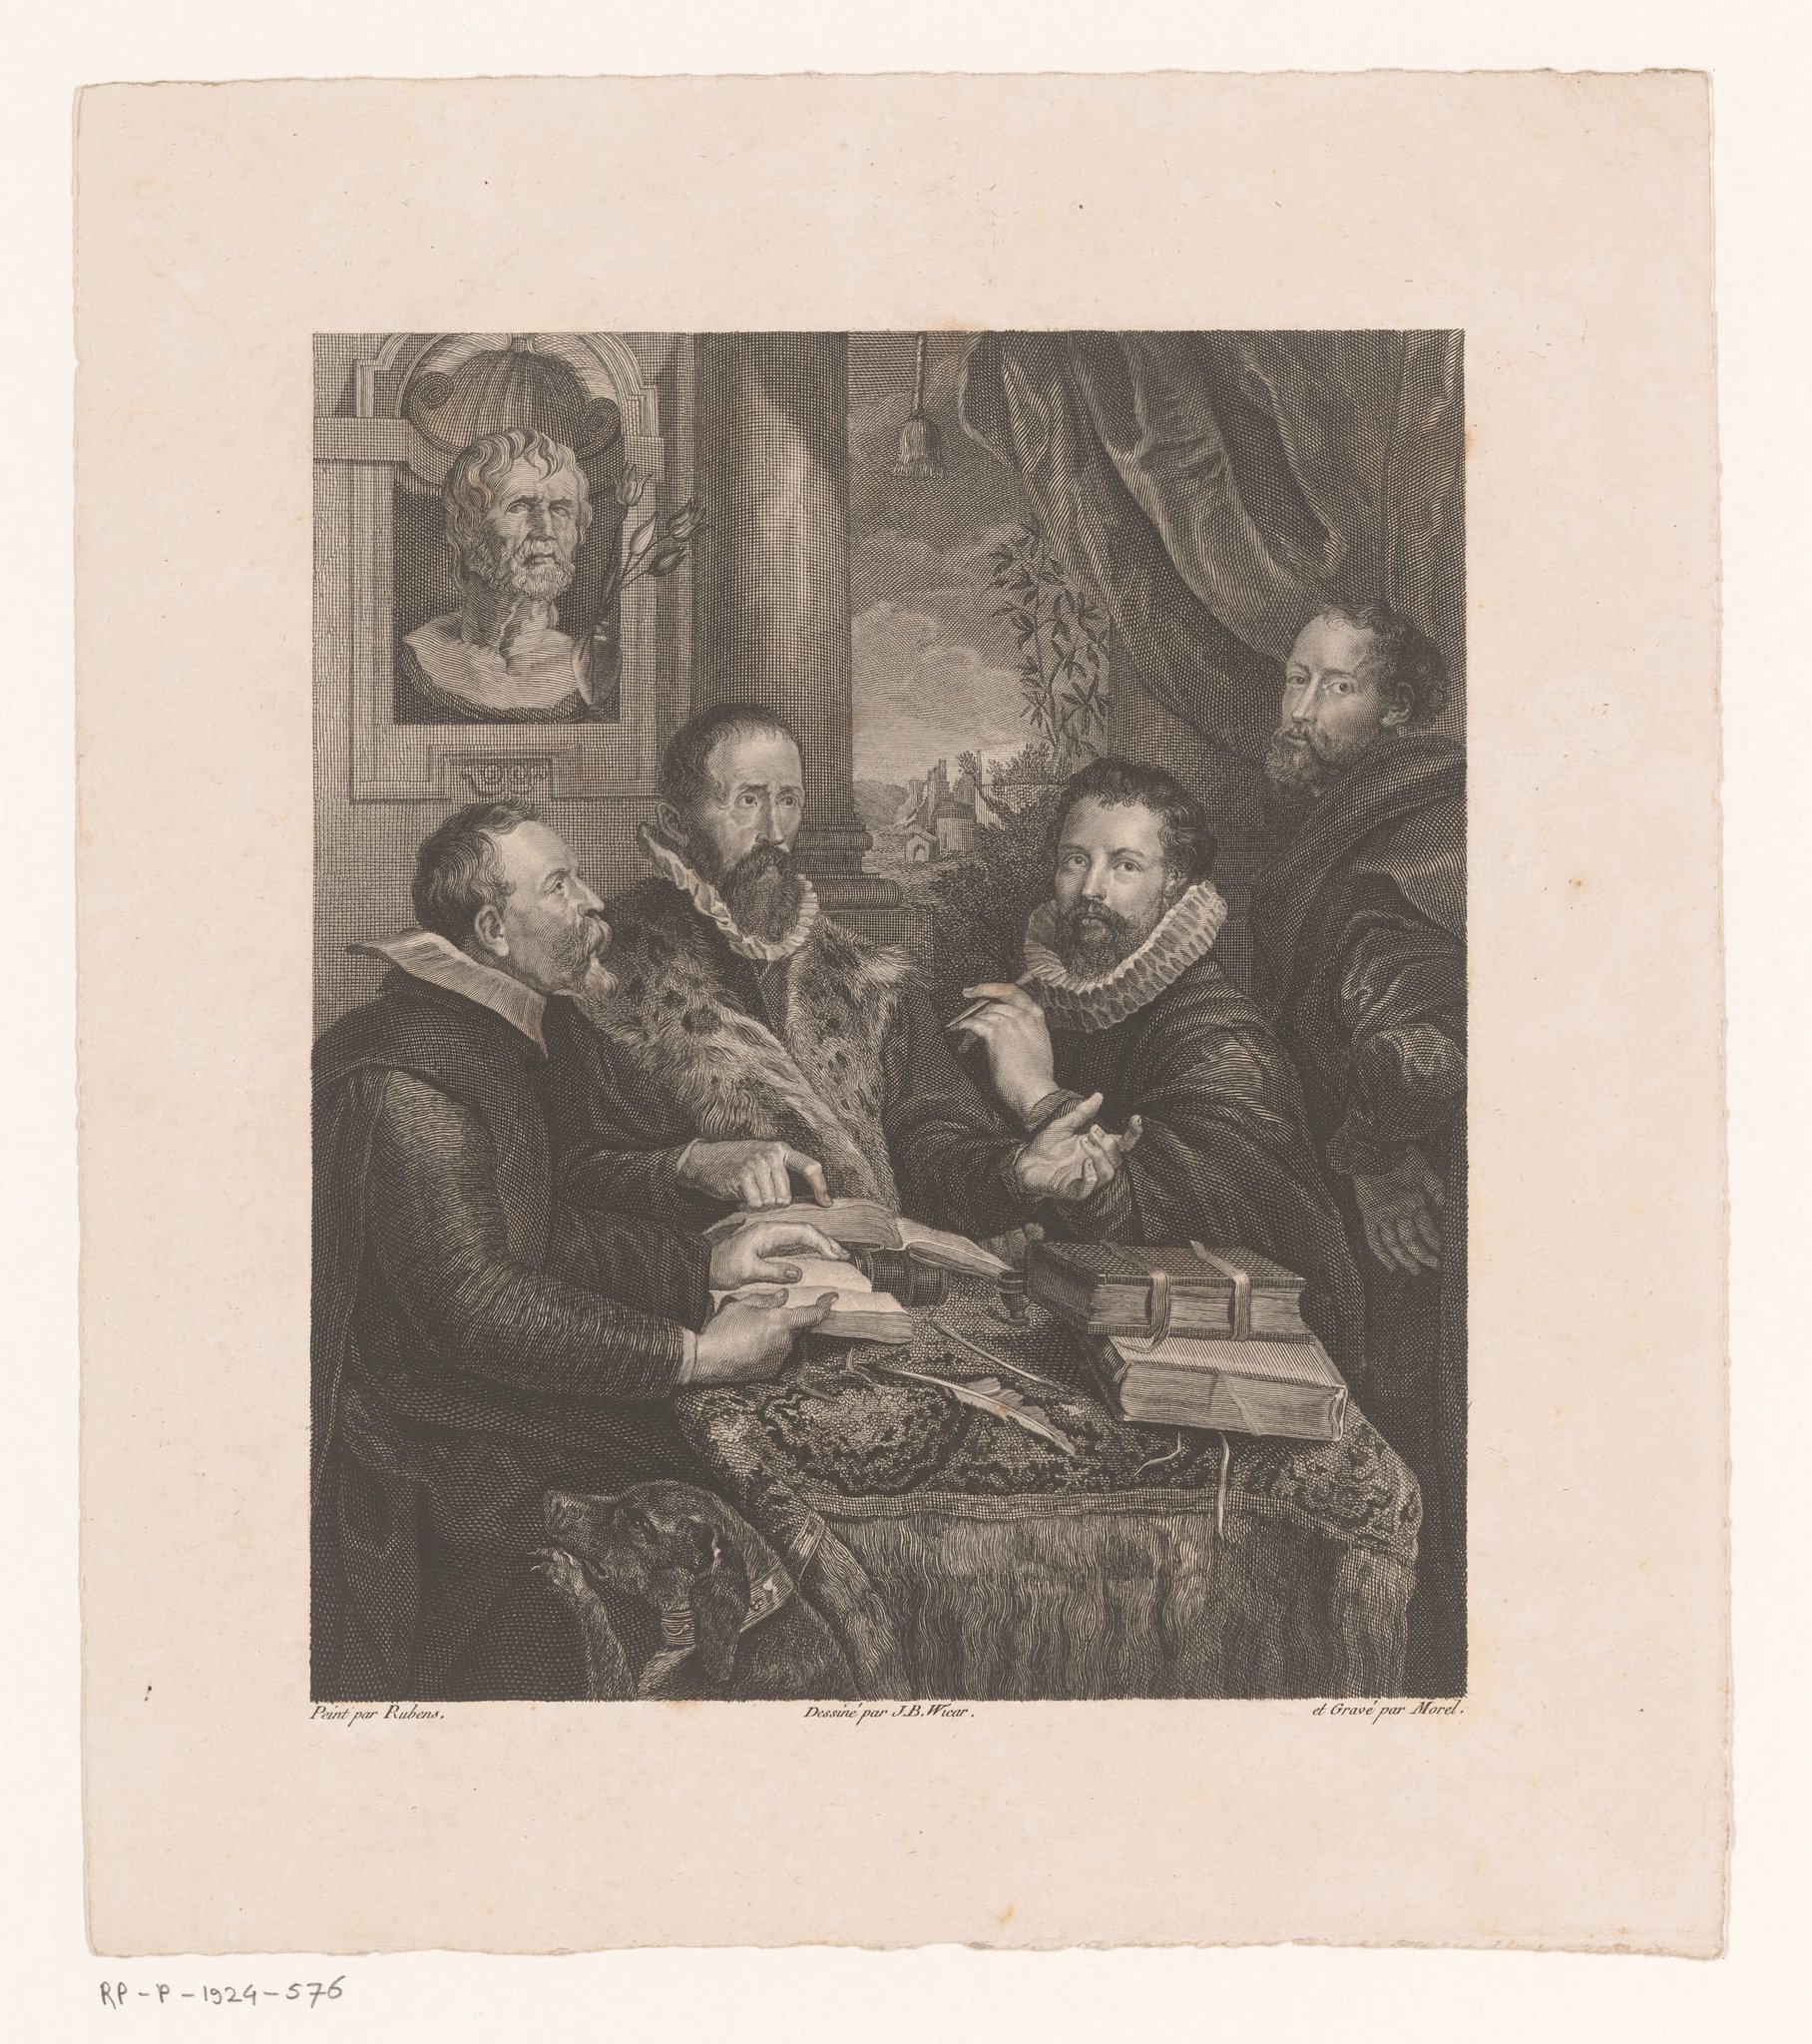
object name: print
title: Portret van Peter Paul Rubens, Philip Rubens, Justus Lipsius en Johannes Woverius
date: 1775-1829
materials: paper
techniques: engraving, etching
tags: johannes woverius, antwerp, painter, draughtsman, peter paul rubens, louvain, justus lipsius, scholar, philosopher, historical persons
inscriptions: collector's mark: Lugt 2233